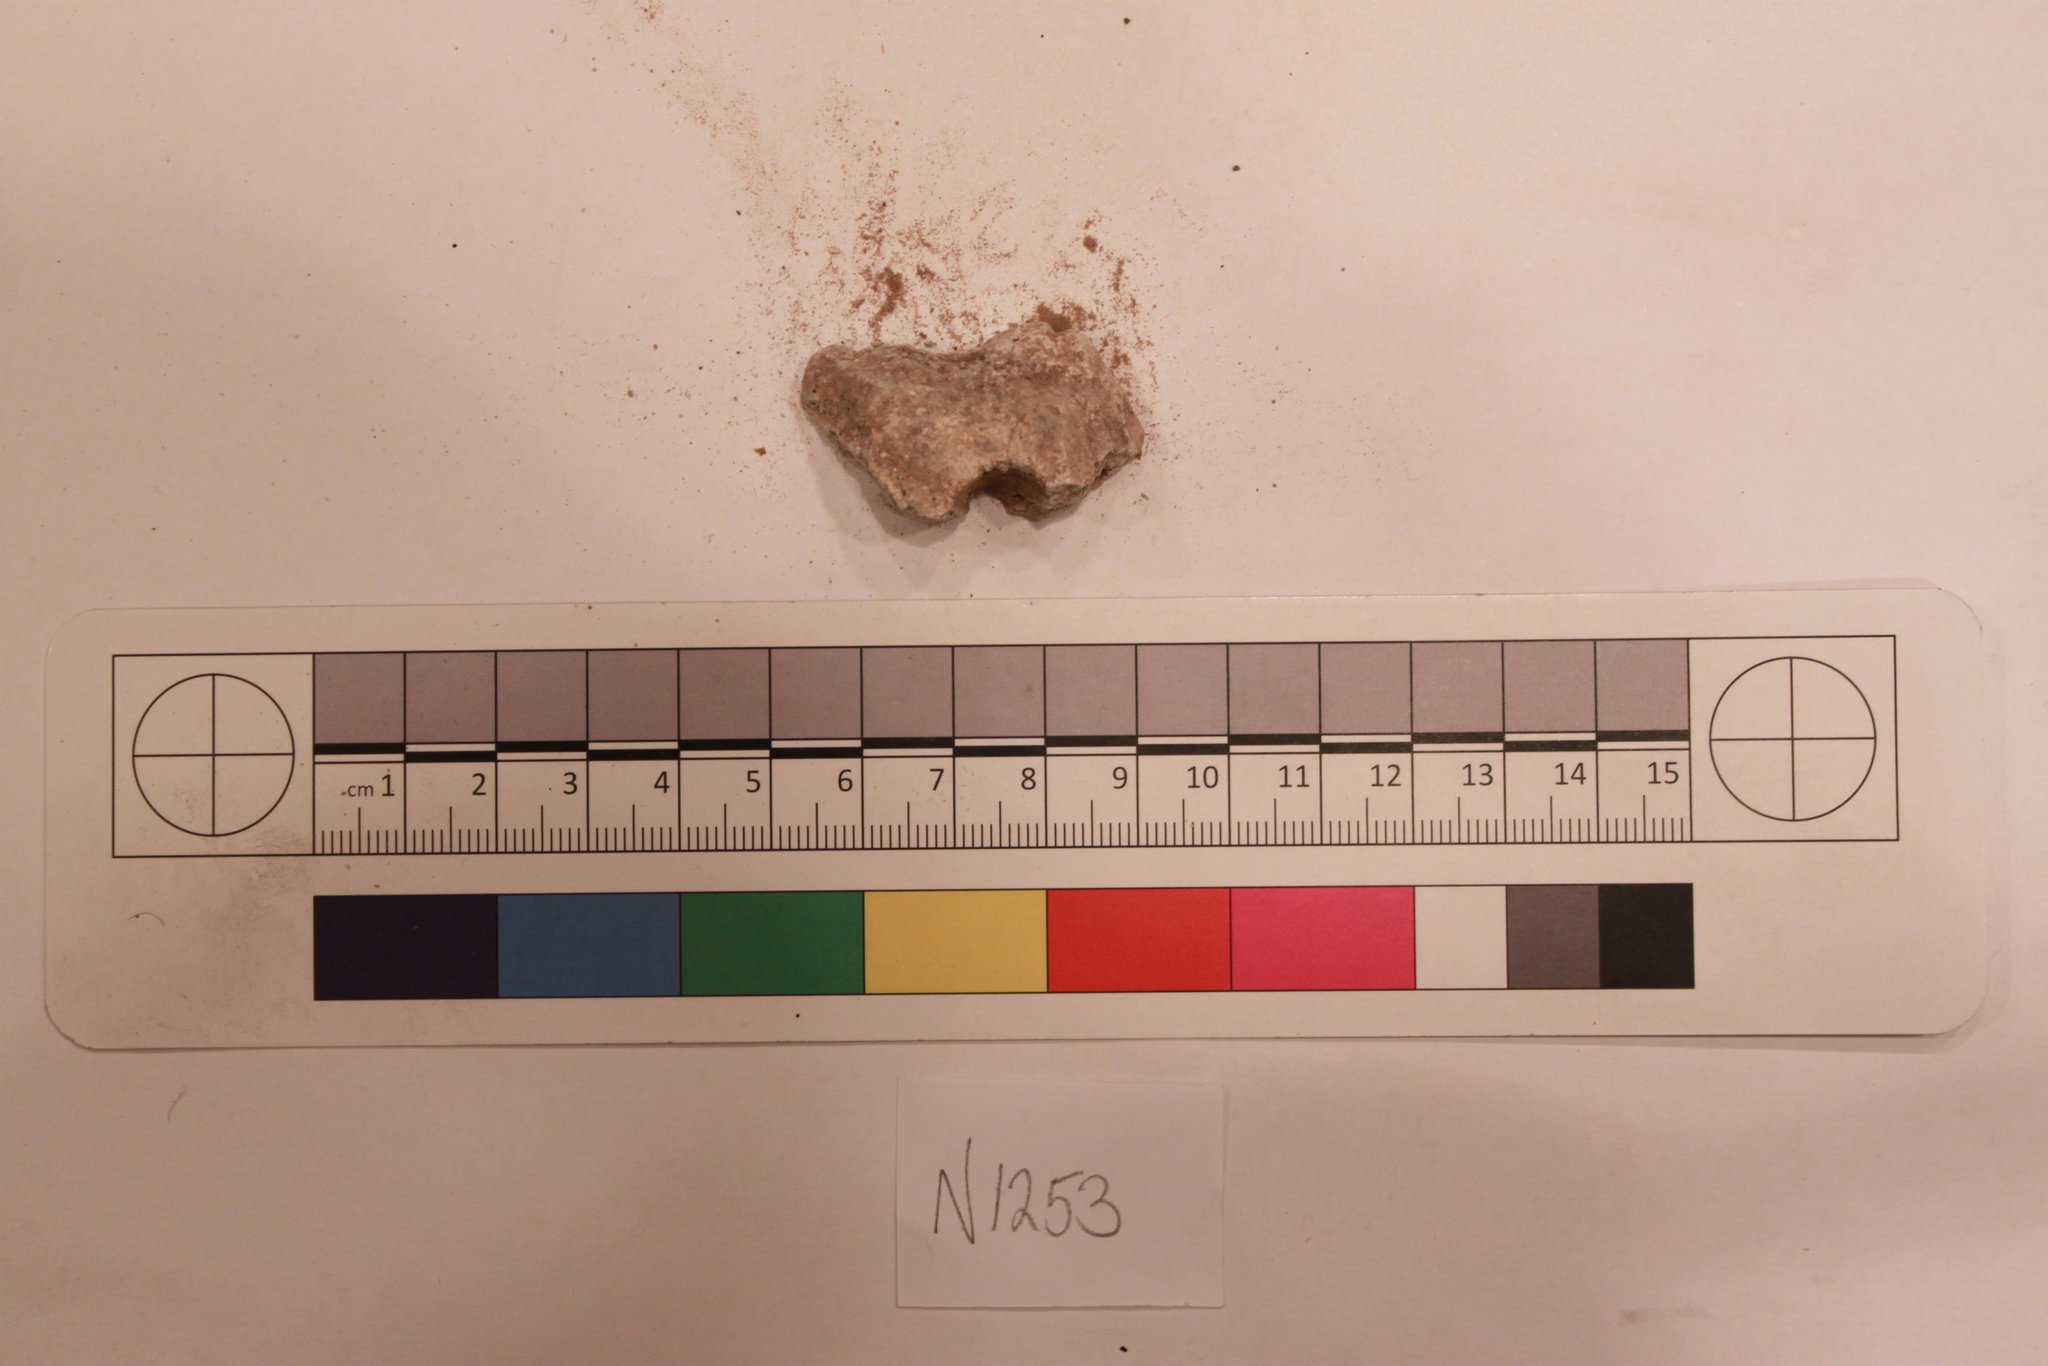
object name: fragment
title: Stucco Fragment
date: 701-1200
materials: plaster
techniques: carving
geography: iran